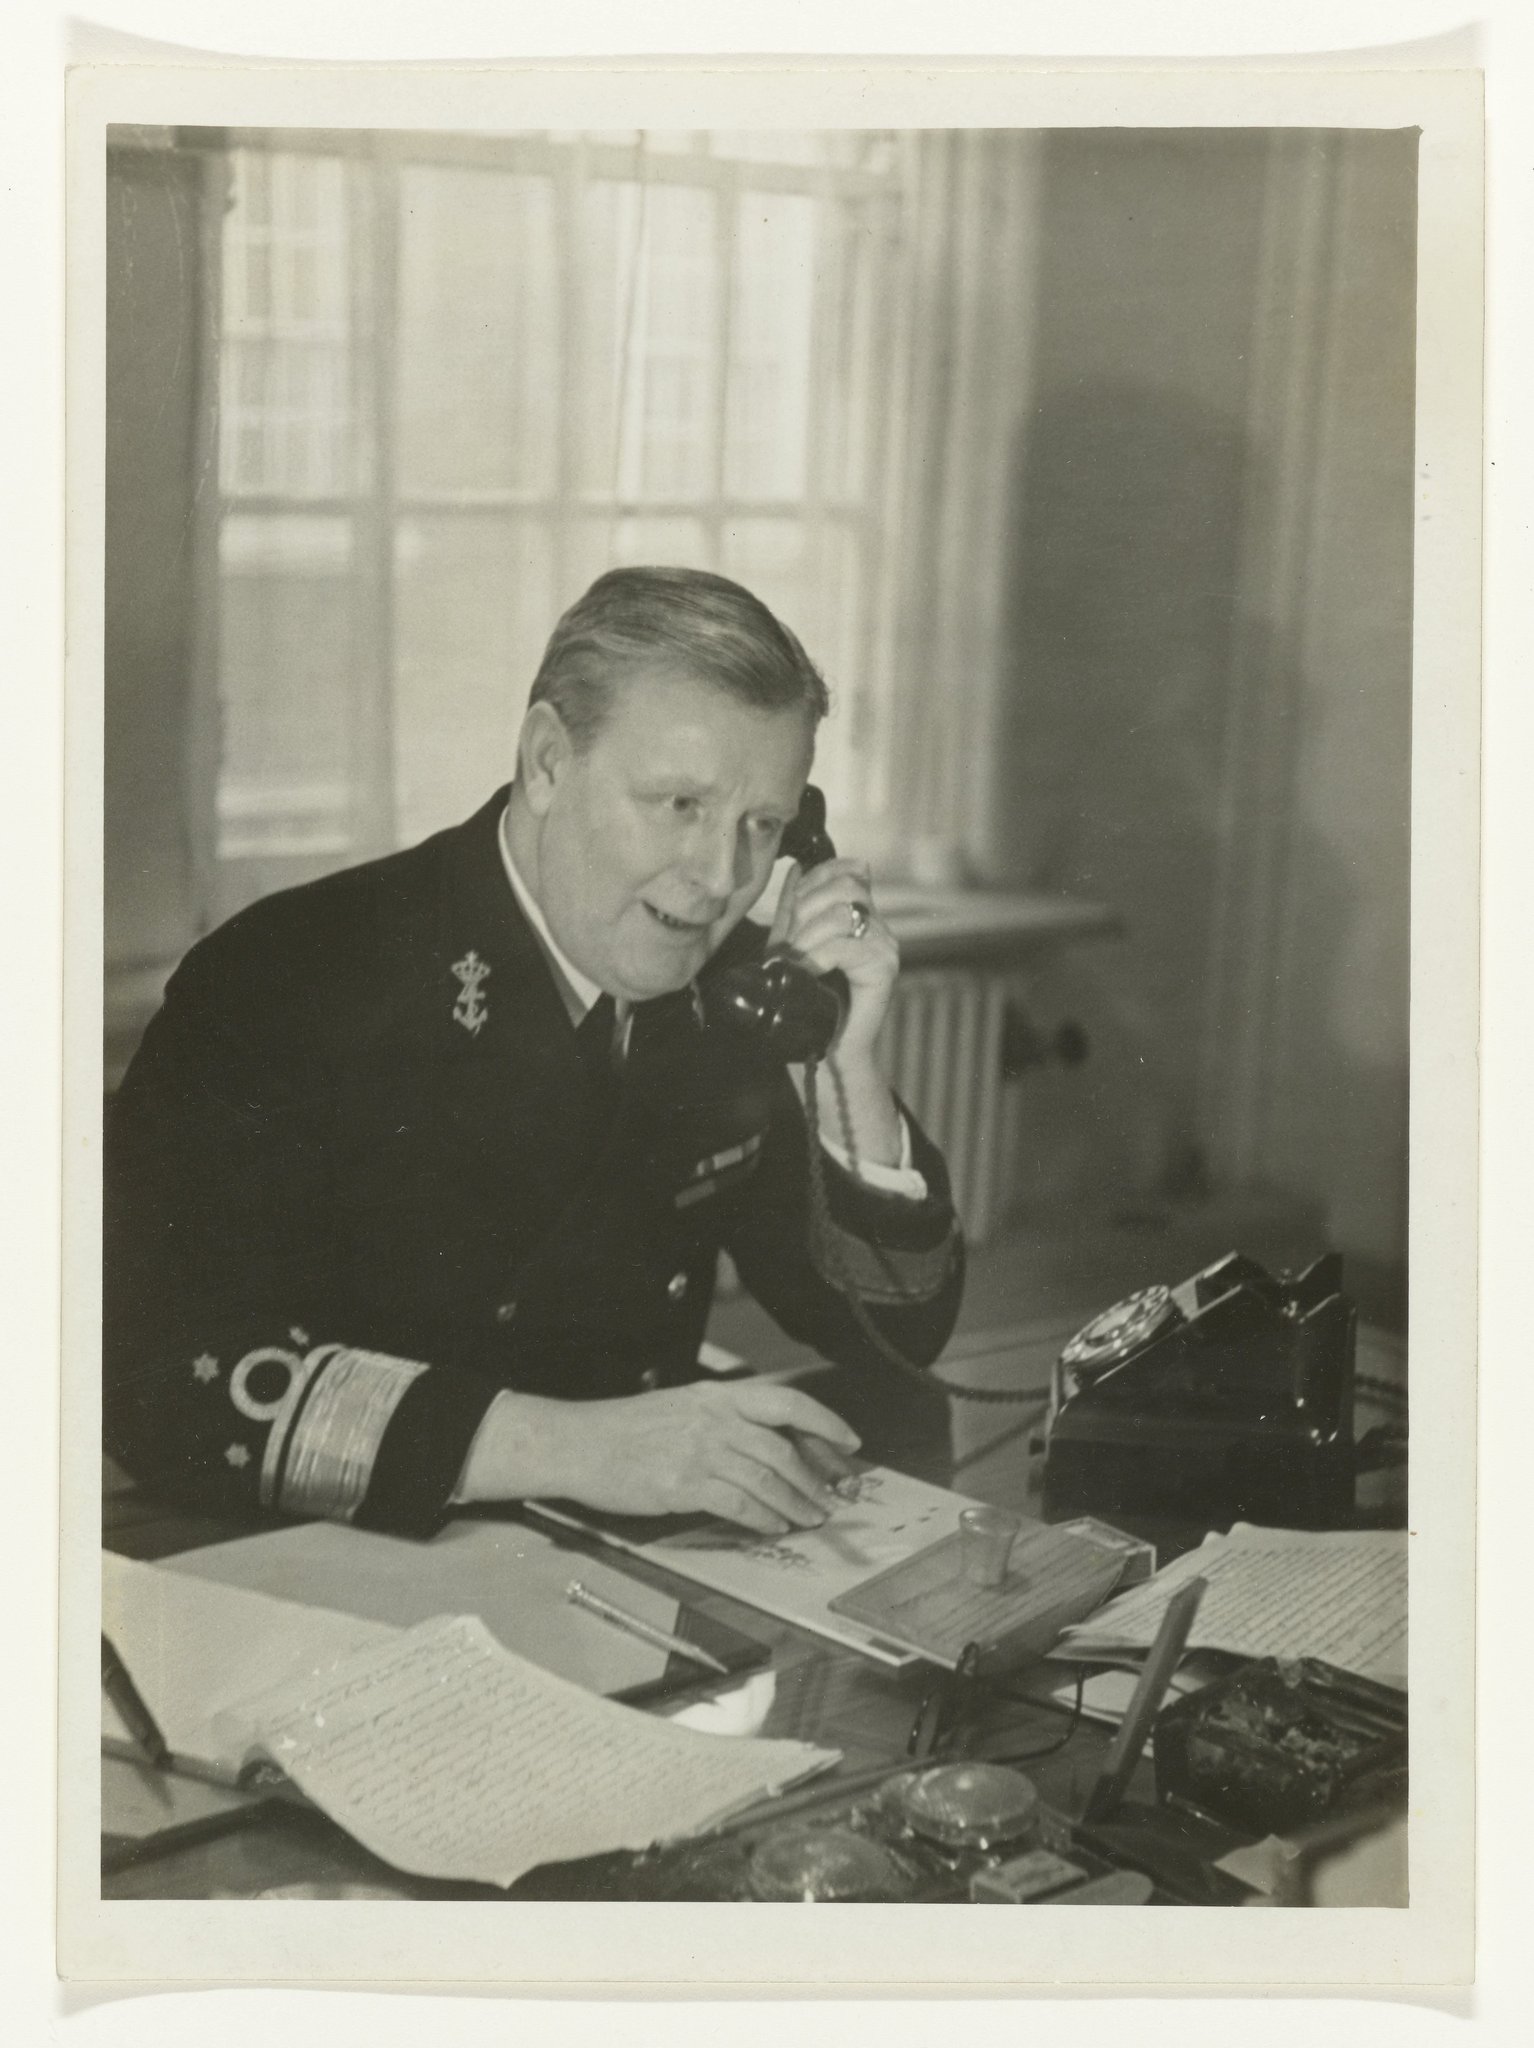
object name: photograph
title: Portret van een telefonerende minister J.Th. Furstner, minister van Marine tijdens de Tweede Wereldoorlog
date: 1940-1945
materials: photographic support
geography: london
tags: london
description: De staf van de Nederlandse Marine was tijdens de Tweede Wereldoorlog gevestigd in Londen onder leiding van admiraal Furstner (1887-1970). Op 14 mei 1940 vertrok vice-admiraal Johannes Theodorus Furstner vanuit Nederland naar Londen. Op 19 mei werd hij benoemd tot bevelhebber der Nederlandse zee- en marineluchtstrijdkrachten die zich in geallieerd gebied bevonden. De bevelhebber was feitelijk slechts betrokken bij personeelsbeleid, administratie, organisatie, onderhoud en nieuwbouw. De operationele leiding lag bij de Engelse Royal Navy. Op 27 juli 1941 werd Furnster minister van marine in het oorlogskabinet en bevelhebber. Op 23 februari 1945 werd J.M. de Booy minister van Marine en Scheepvaart. Furstner bleef de bevelhebber. De foto is afkomstig uit de nalatenschap van kunstenaar Cor Visser.